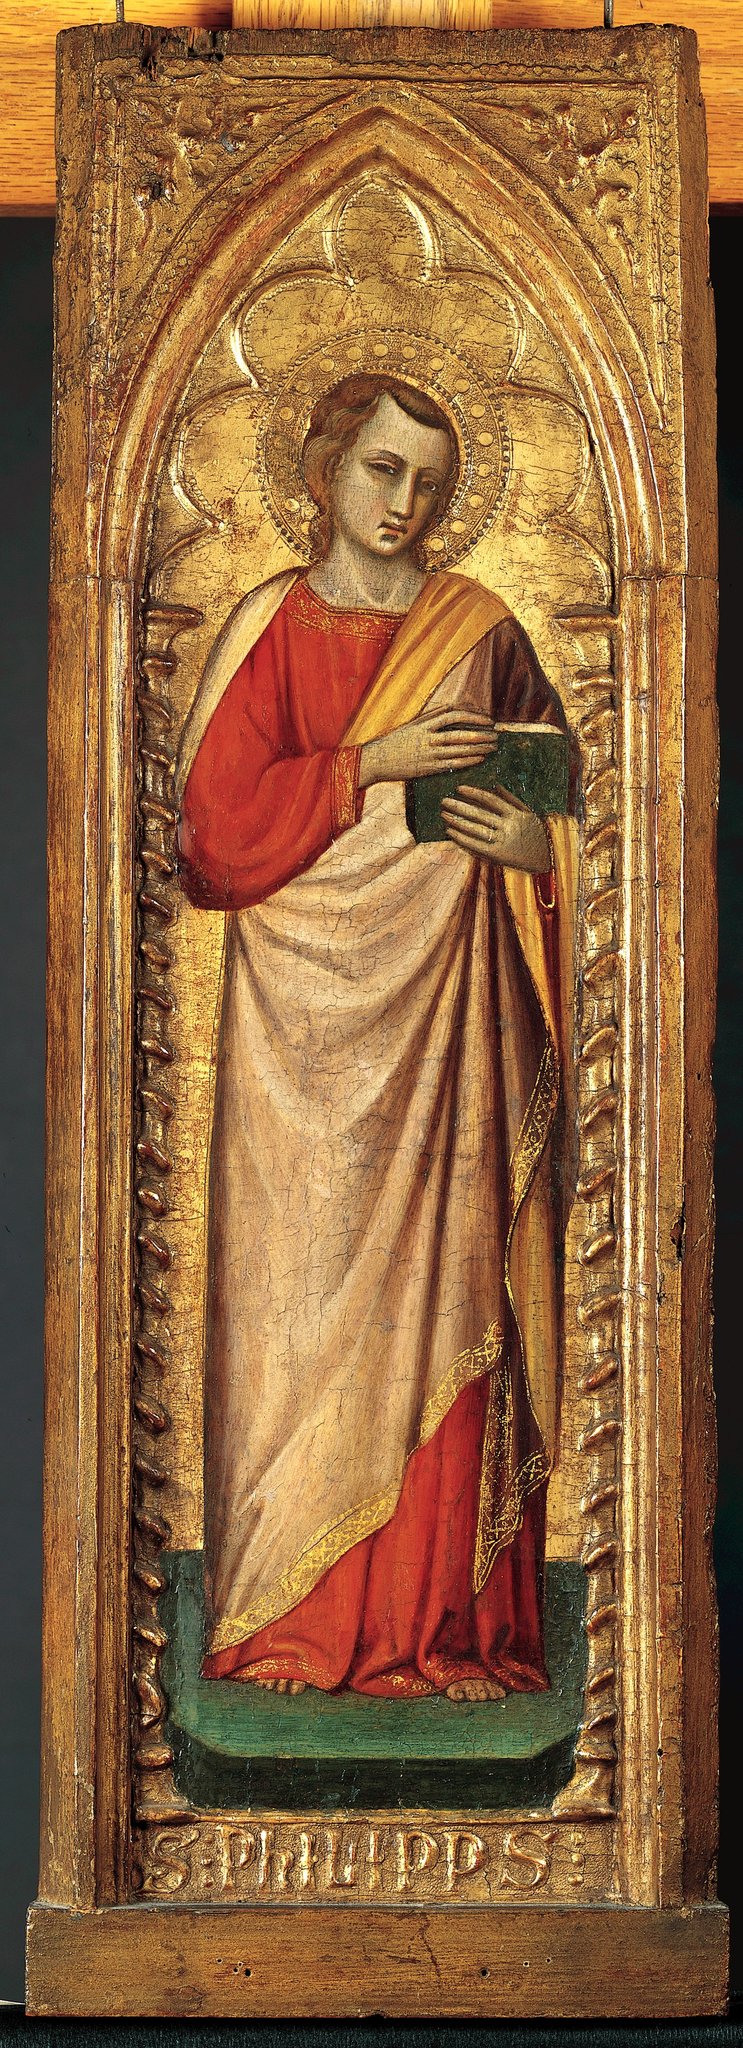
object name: frame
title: One of a pair of pilaster panels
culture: italian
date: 1385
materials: wood